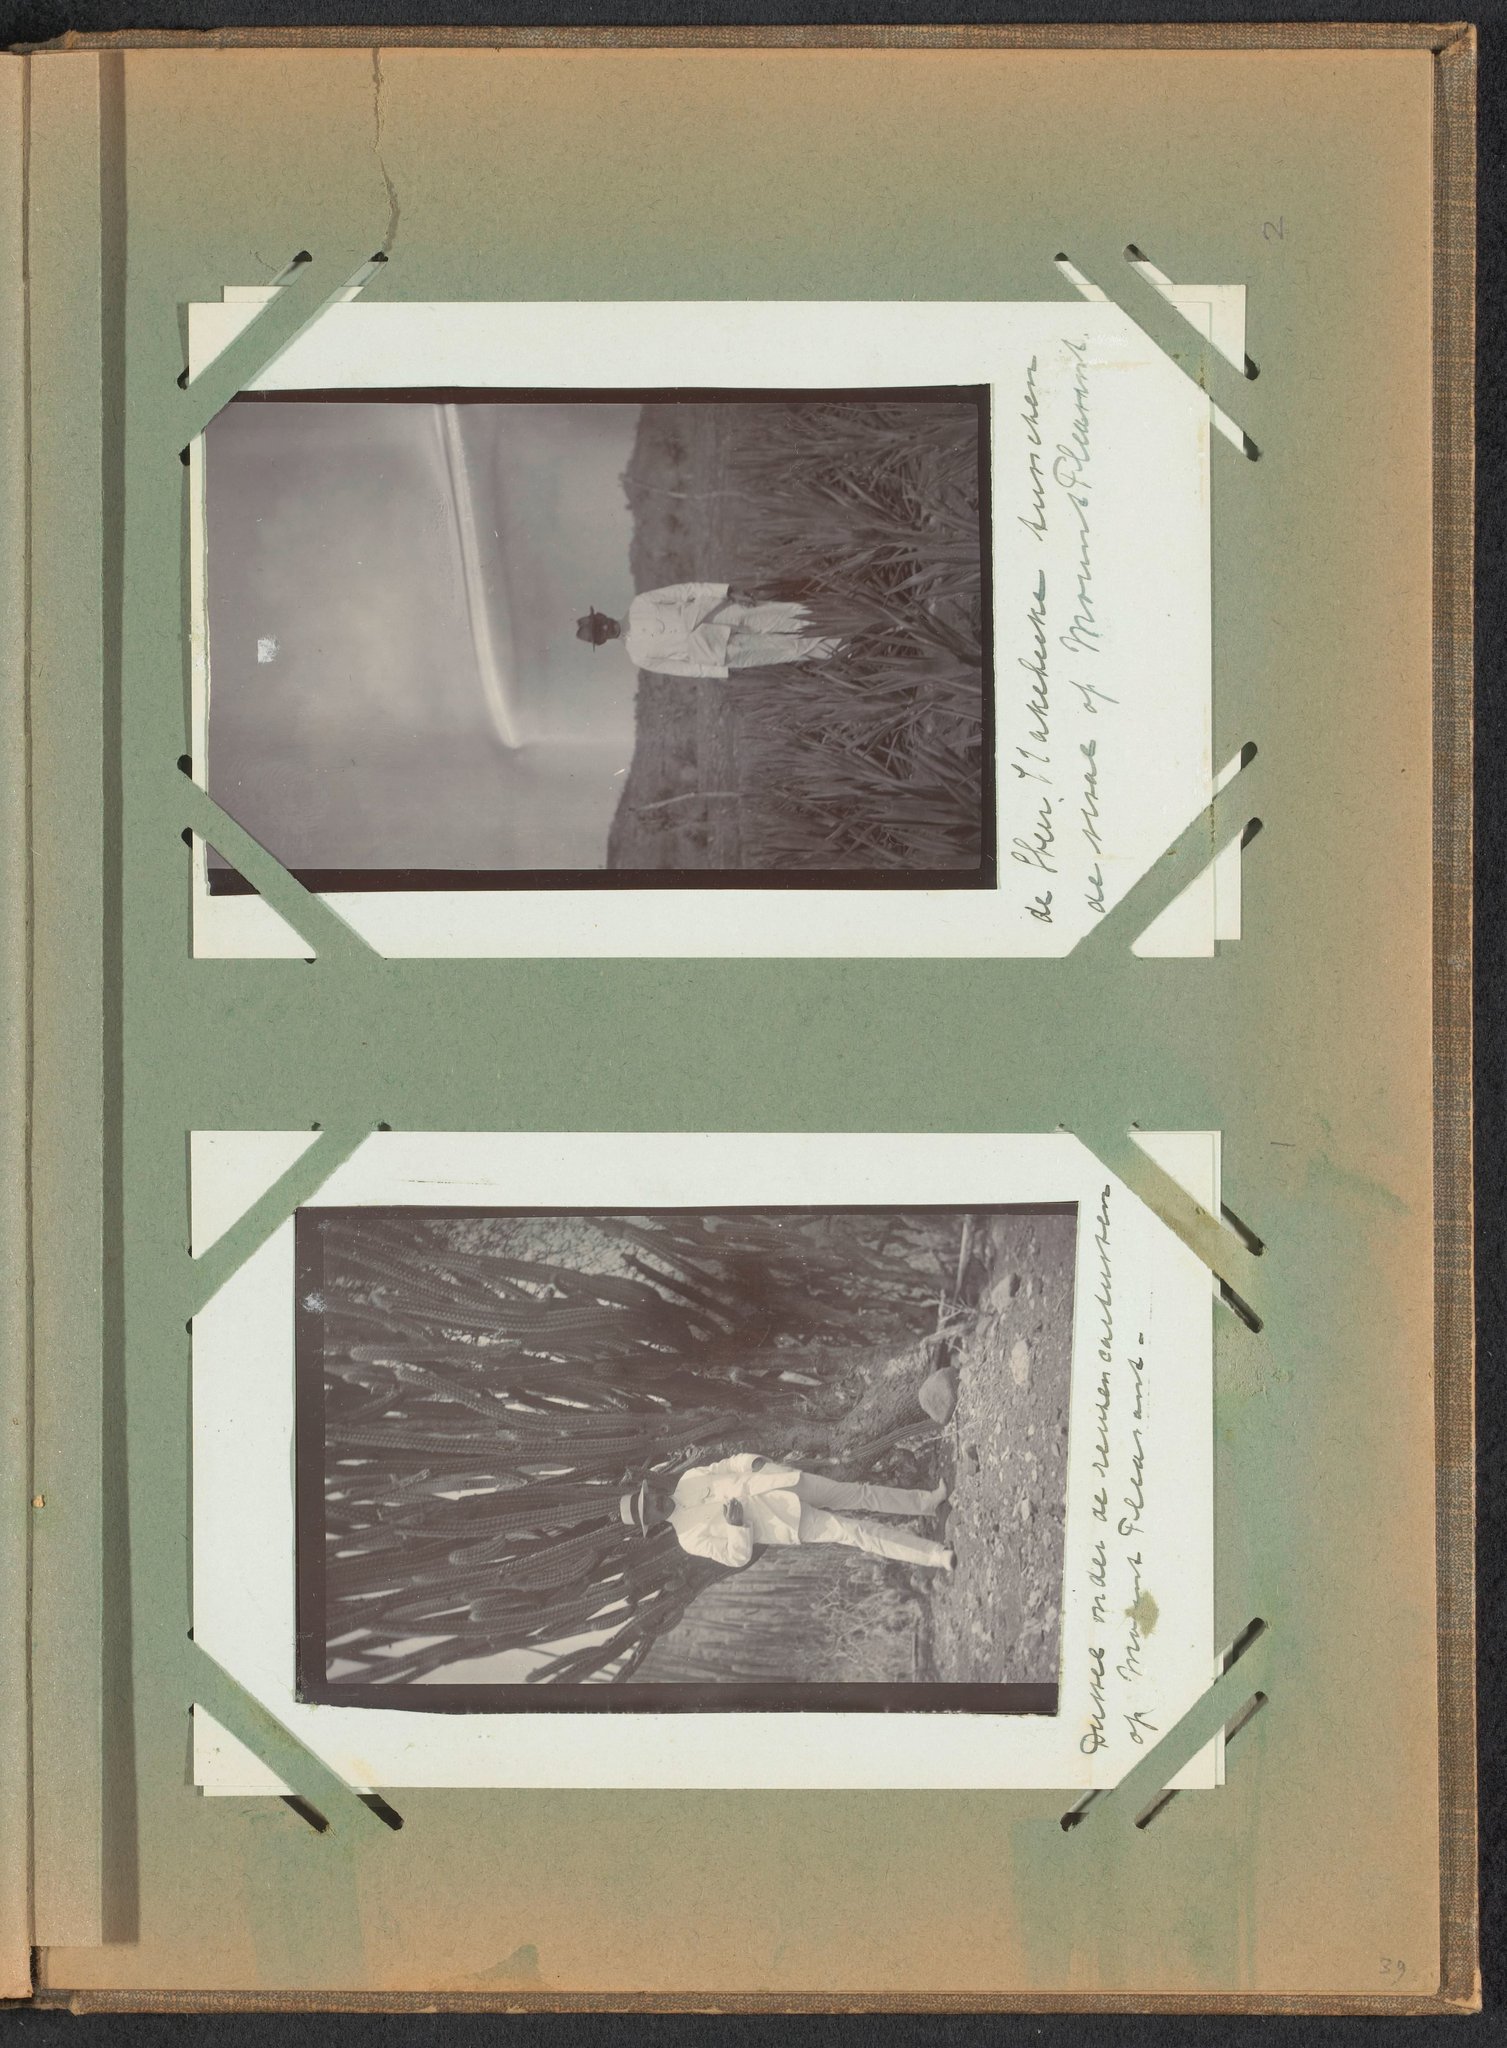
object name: photograph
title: de Heer Hakebeeke tusschen de sisal op Mount Pleasant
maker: Anonymous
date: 1912-1913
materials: paper, photographic support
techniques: gelatin silver print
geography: curacao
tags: (non-fruit) products of plants or trees: sisal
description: Man (Hakebeeke) poserend tussen de sisalplanten op Mount Pleasant op Curaçao. Onderdeel van het fotoalbum uit ca. 1912-1913 met 92 foto's van de plantages Peperpot en Dordrecht in Suriname en Mount Pleasant op Curaçao.